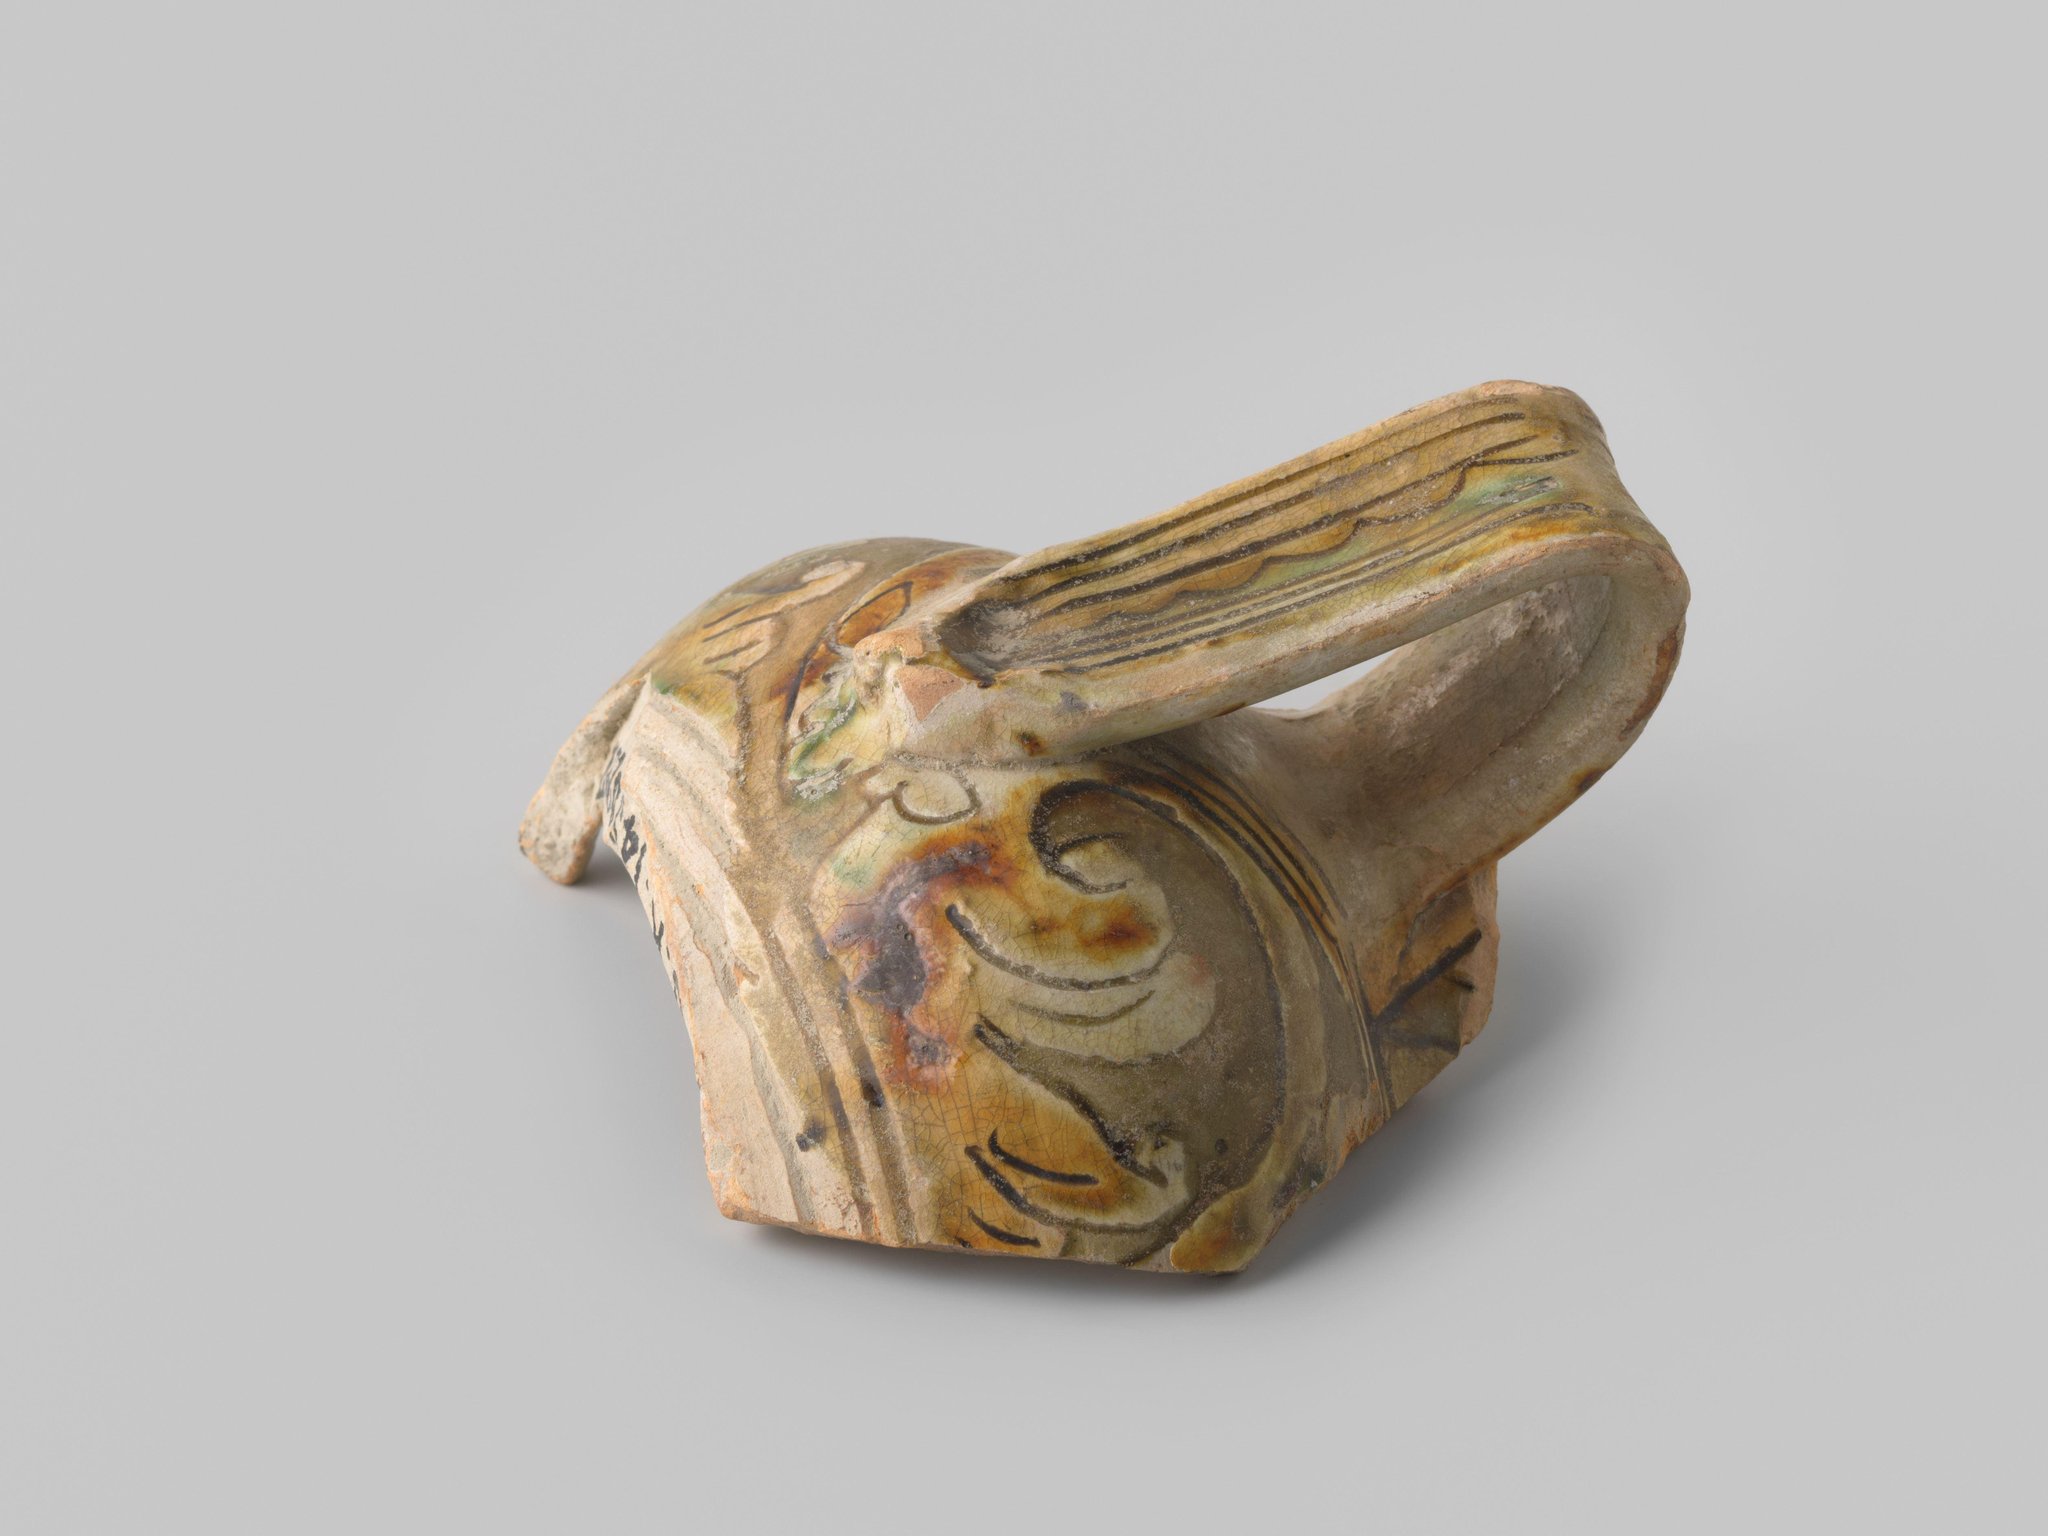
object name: sherd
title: Fragment (voet) met rossige scherf, met oor, aan de voorzijde voorzien van florale vormen en banen in sgraffito-techniek met bruin, groen en beige glazuur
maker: Anonymous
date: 1200-1899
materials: earthenware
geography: italy